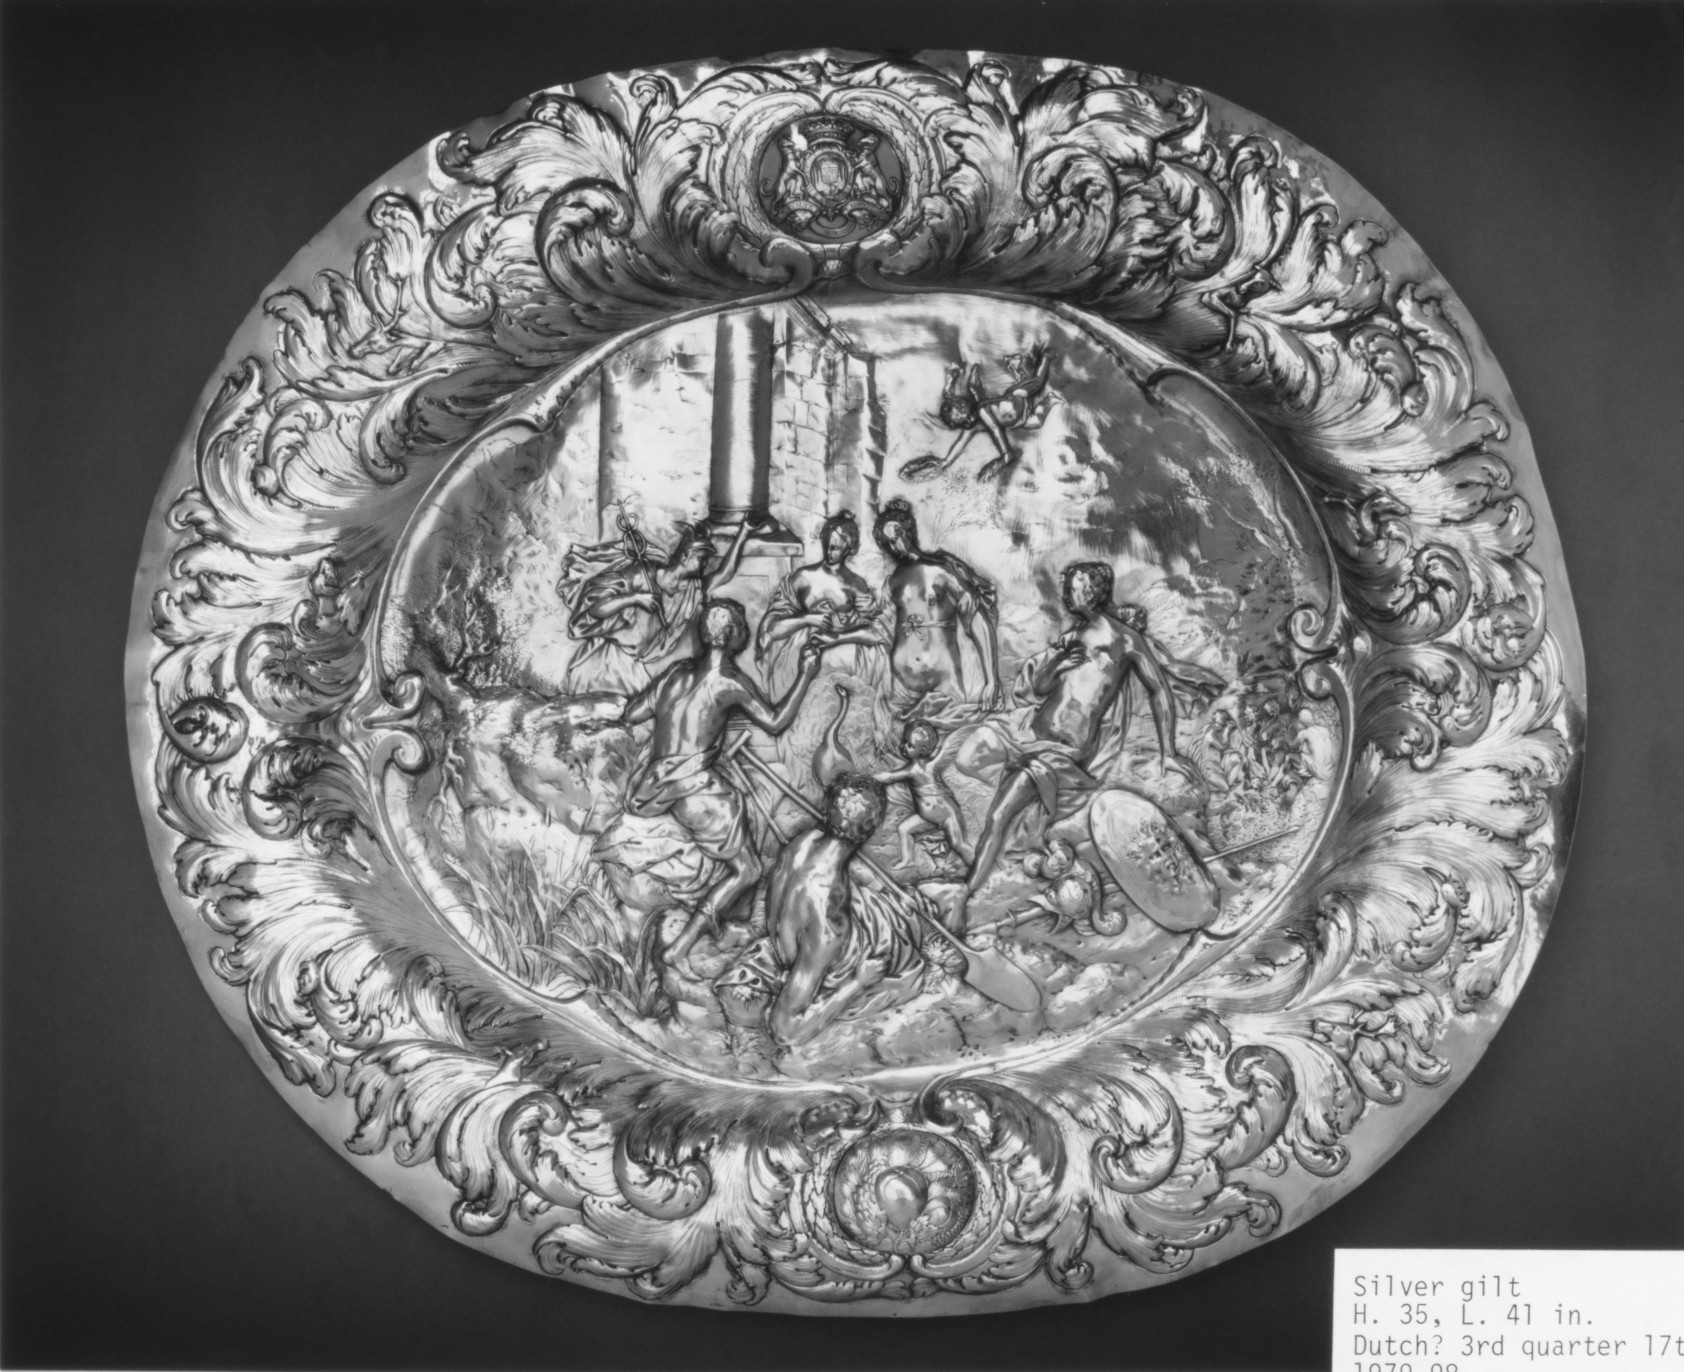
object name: charger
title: Judgment of Paris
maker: hans von aachen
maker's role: artist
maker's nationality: german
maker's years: 1552-1616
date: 1665-1680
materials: silver gilt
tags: men,women,putti,coat of arms